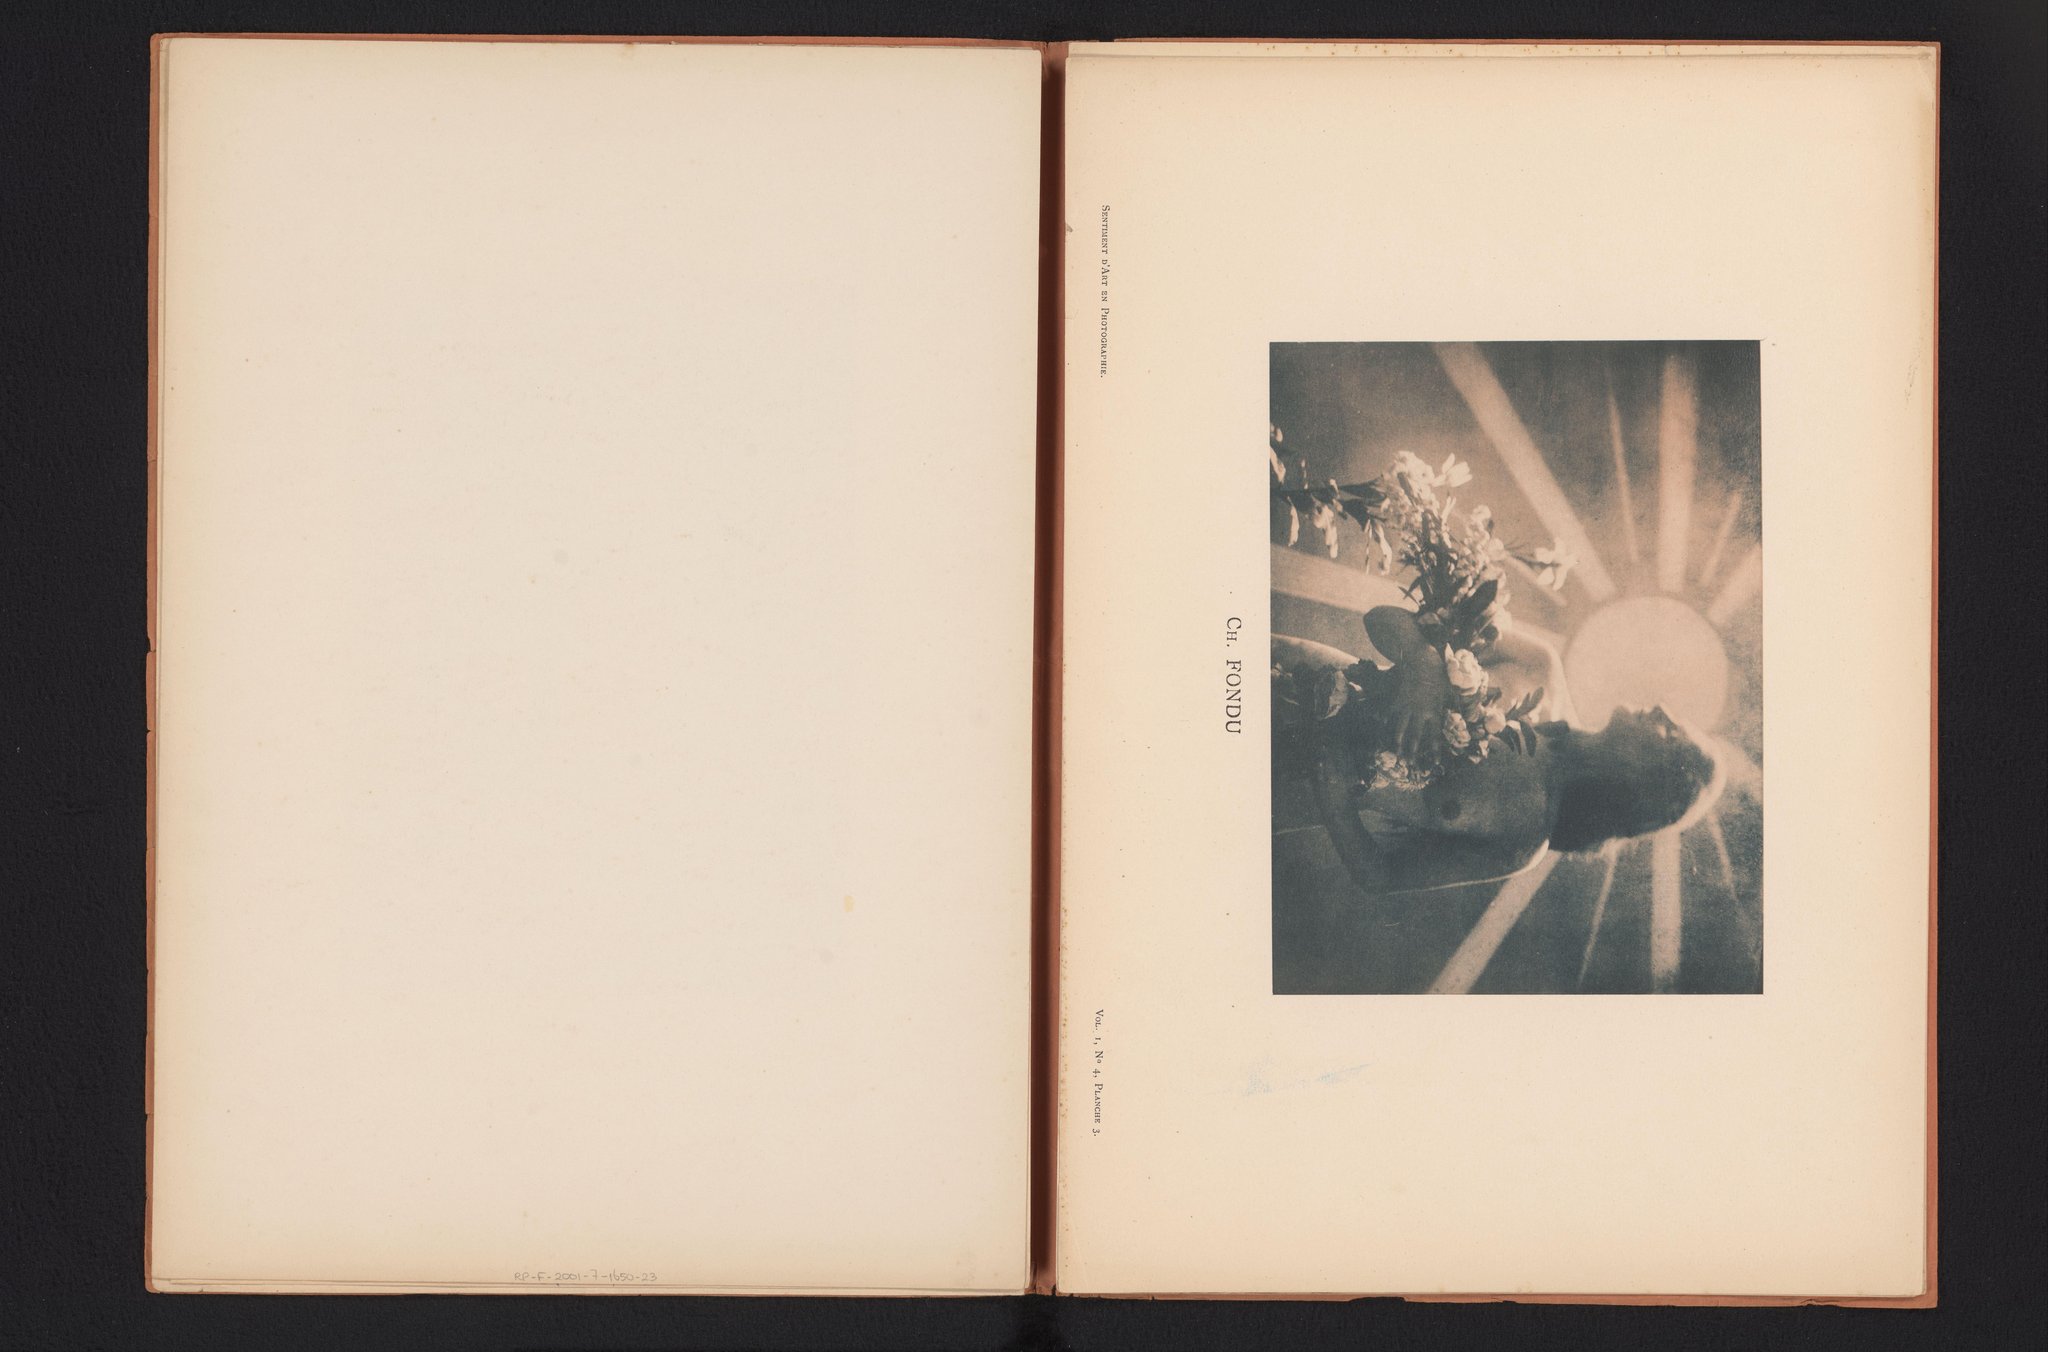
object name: photomechanical print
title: Portret van een onbekende halfnaakte vrouw met bloemen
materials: paper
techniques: photograph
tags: flowers, historical persons - bb - woman, woman (showing herself) undressed, quasi-nude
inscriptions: number: ‘Vol. 1, No 4, Planche 3.’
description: Deze prent maakt deel uit van 8 omslagen met 22 tekstbladen en 89 prenten op losse bladen in en tussen de omslagen.